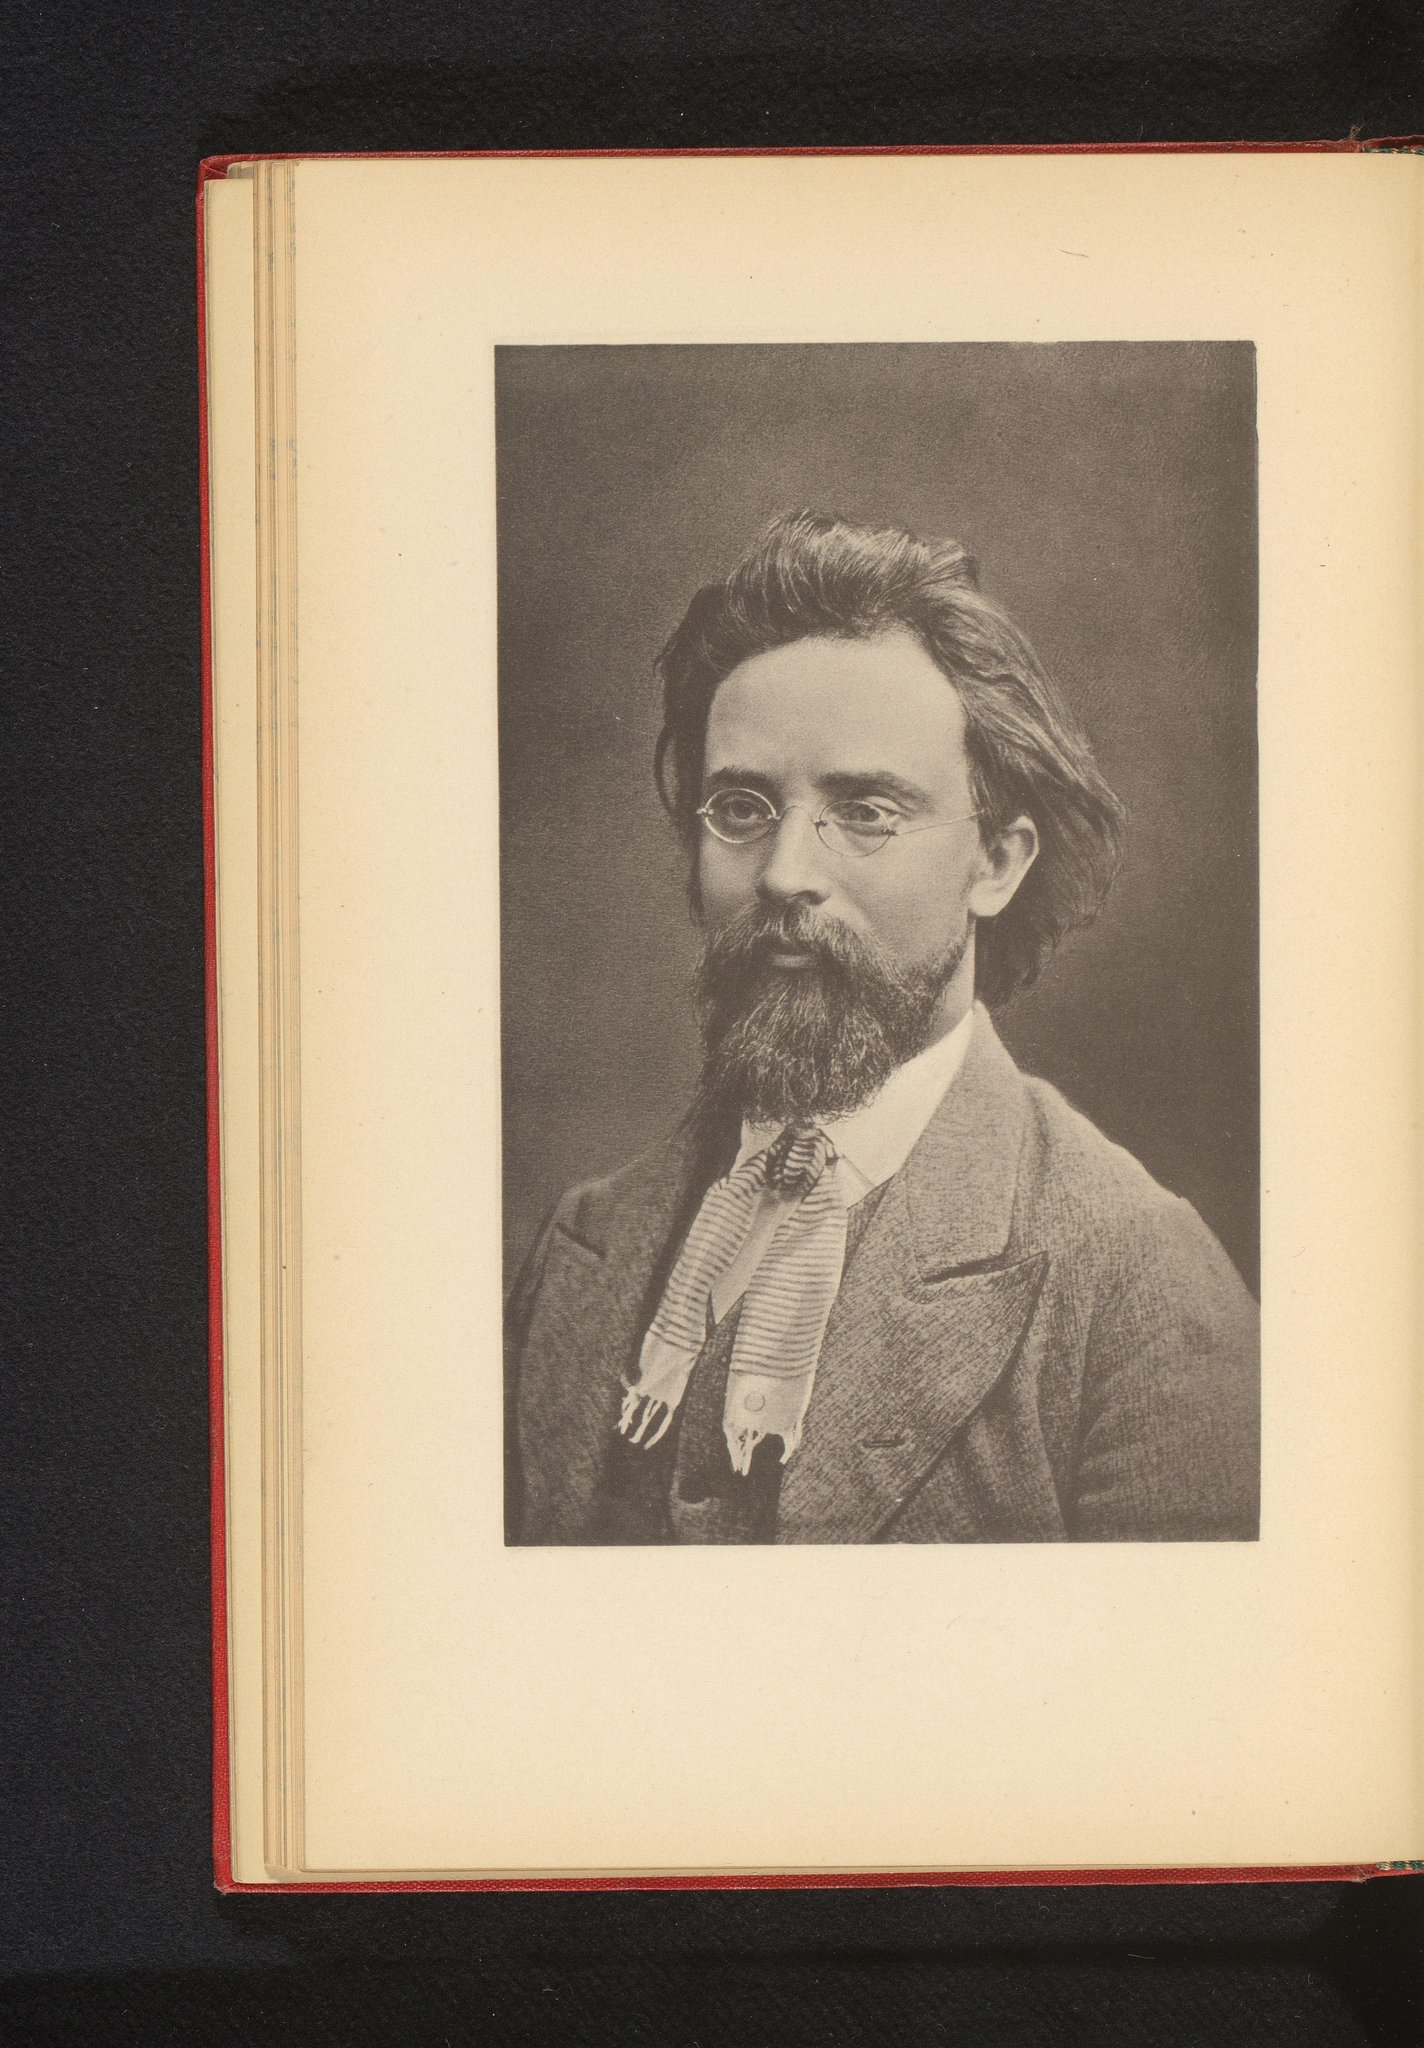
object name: page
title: Portret van Walter Runeberg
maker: Anonymous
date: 1873-1883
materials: paper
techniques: photograph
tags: sculptor, portrait, self-portrait of sculptor